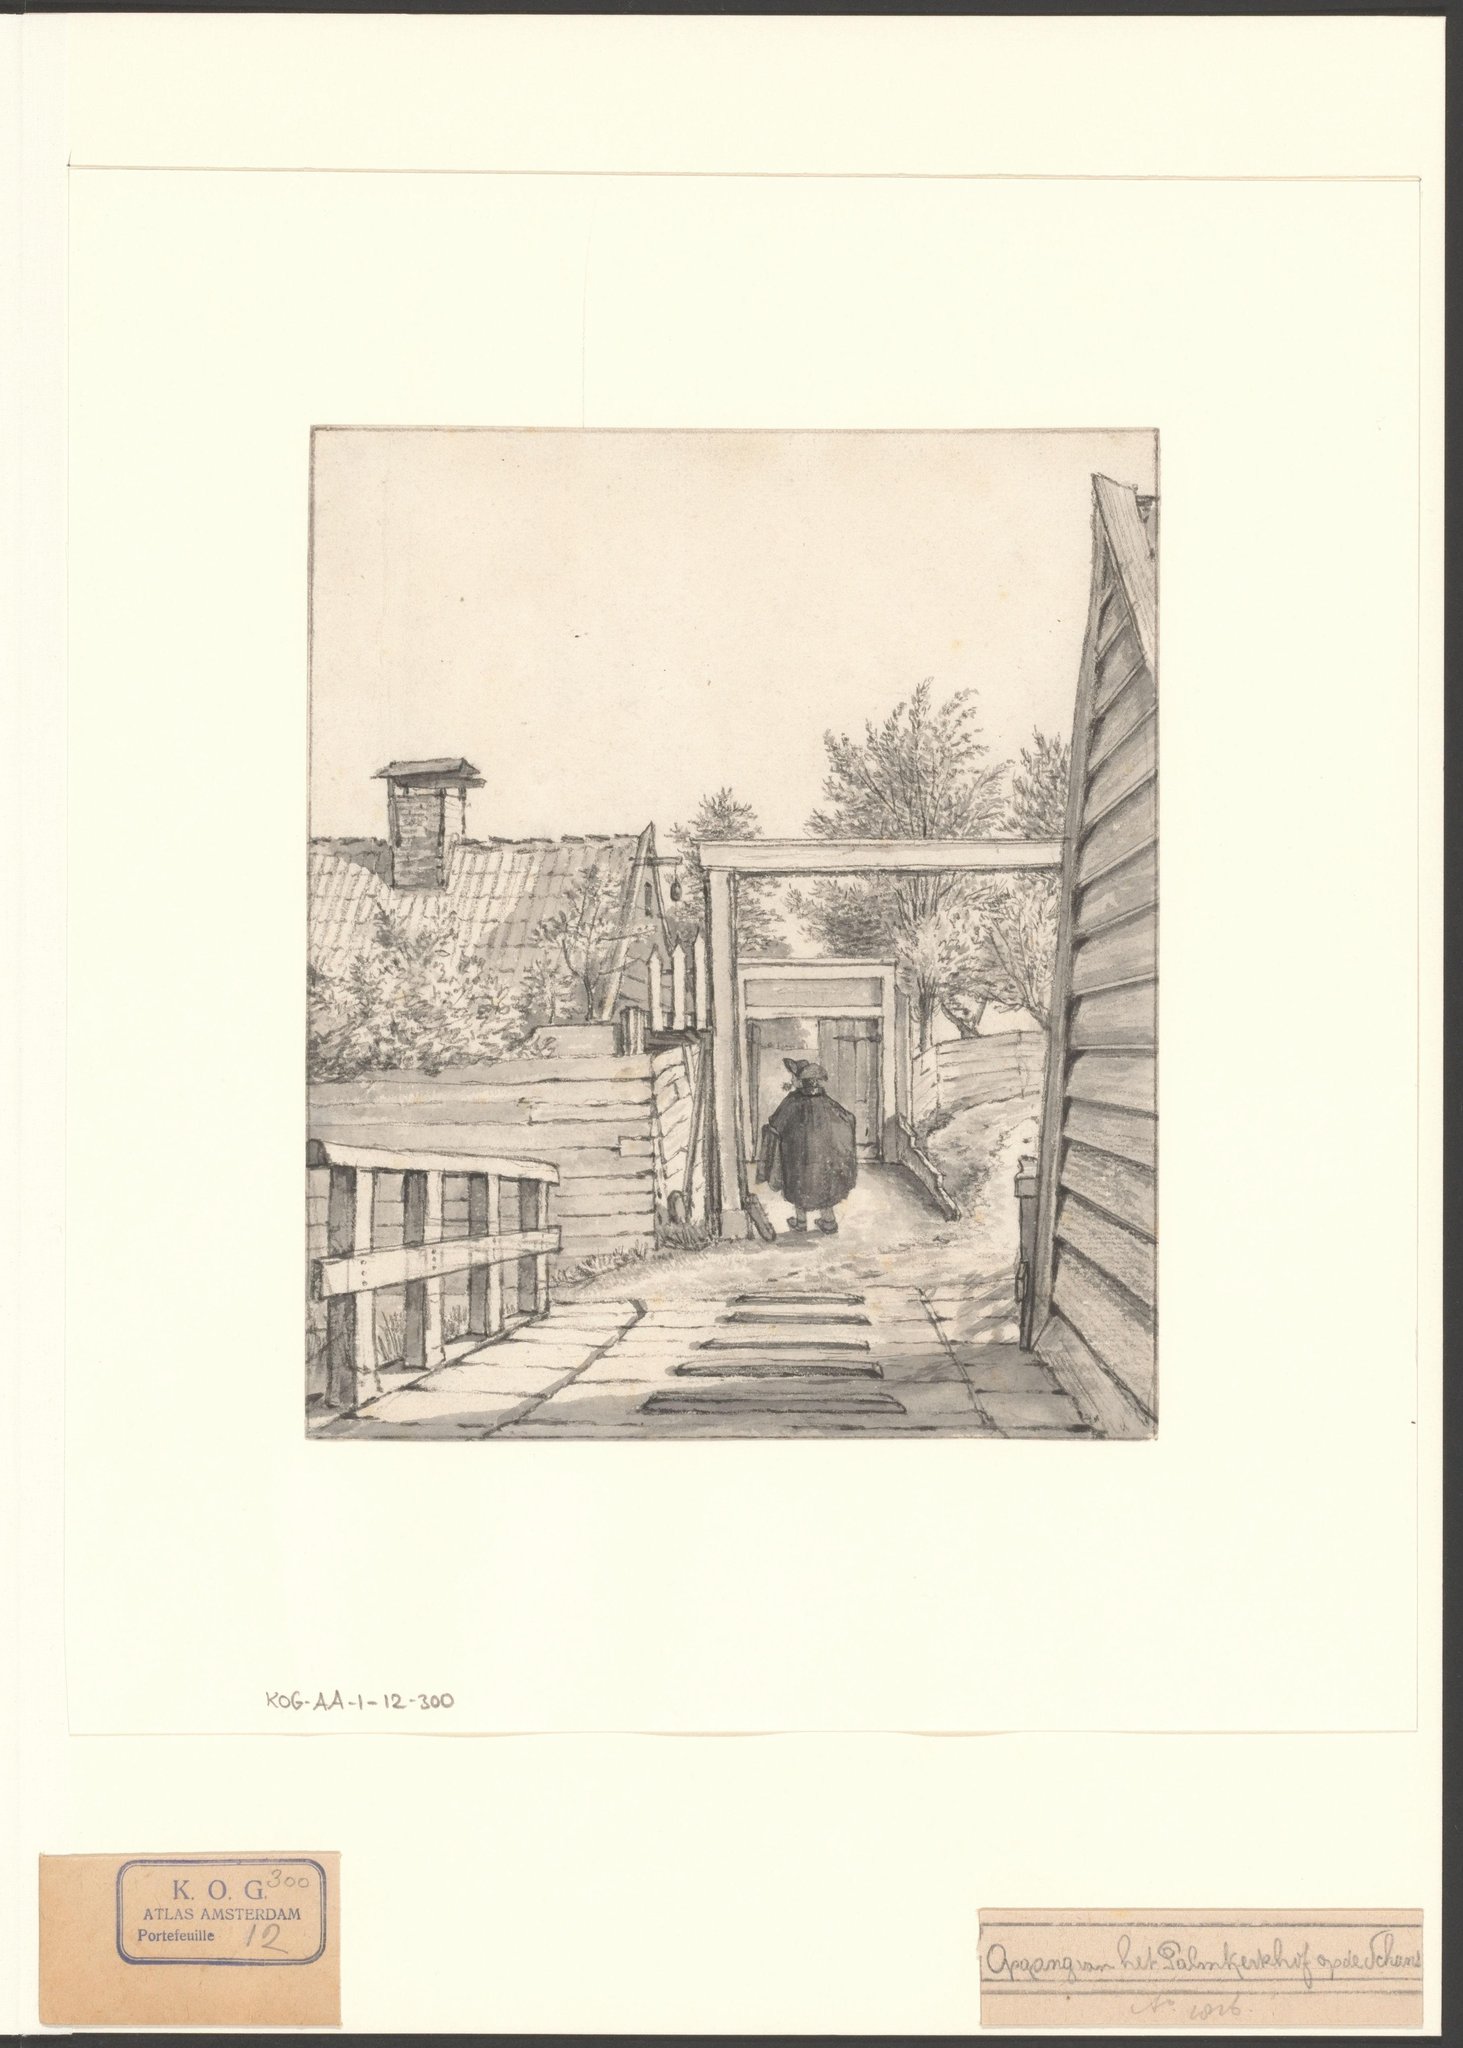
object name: drawing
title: Gezicht op de weg naar het Palmkerkhof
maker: gerrit lamberts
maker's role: bookseller, draughtsman, print maker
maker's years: 1776-1850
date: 1816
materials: chalk, ink, paper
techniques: brush, pen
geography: amsterdam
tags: city-view in general; 'veduta', gate, entrance, cemetery, park-like burying ground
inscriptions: collector's mark: ‘12’ Lugt 1641b, collector's mark: Lugt 2138d, inscription: ‘Port. 12-300’, inscription: ‘Opgang van het Palmkerkhof op de Schans’, signature, date and inscription: ‘Opgang van het (...) G. Lamberts. 1816.’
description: Onderwerpsrubriek binnen de Atlas Amsterdam: Sarphatistraat, Schans.